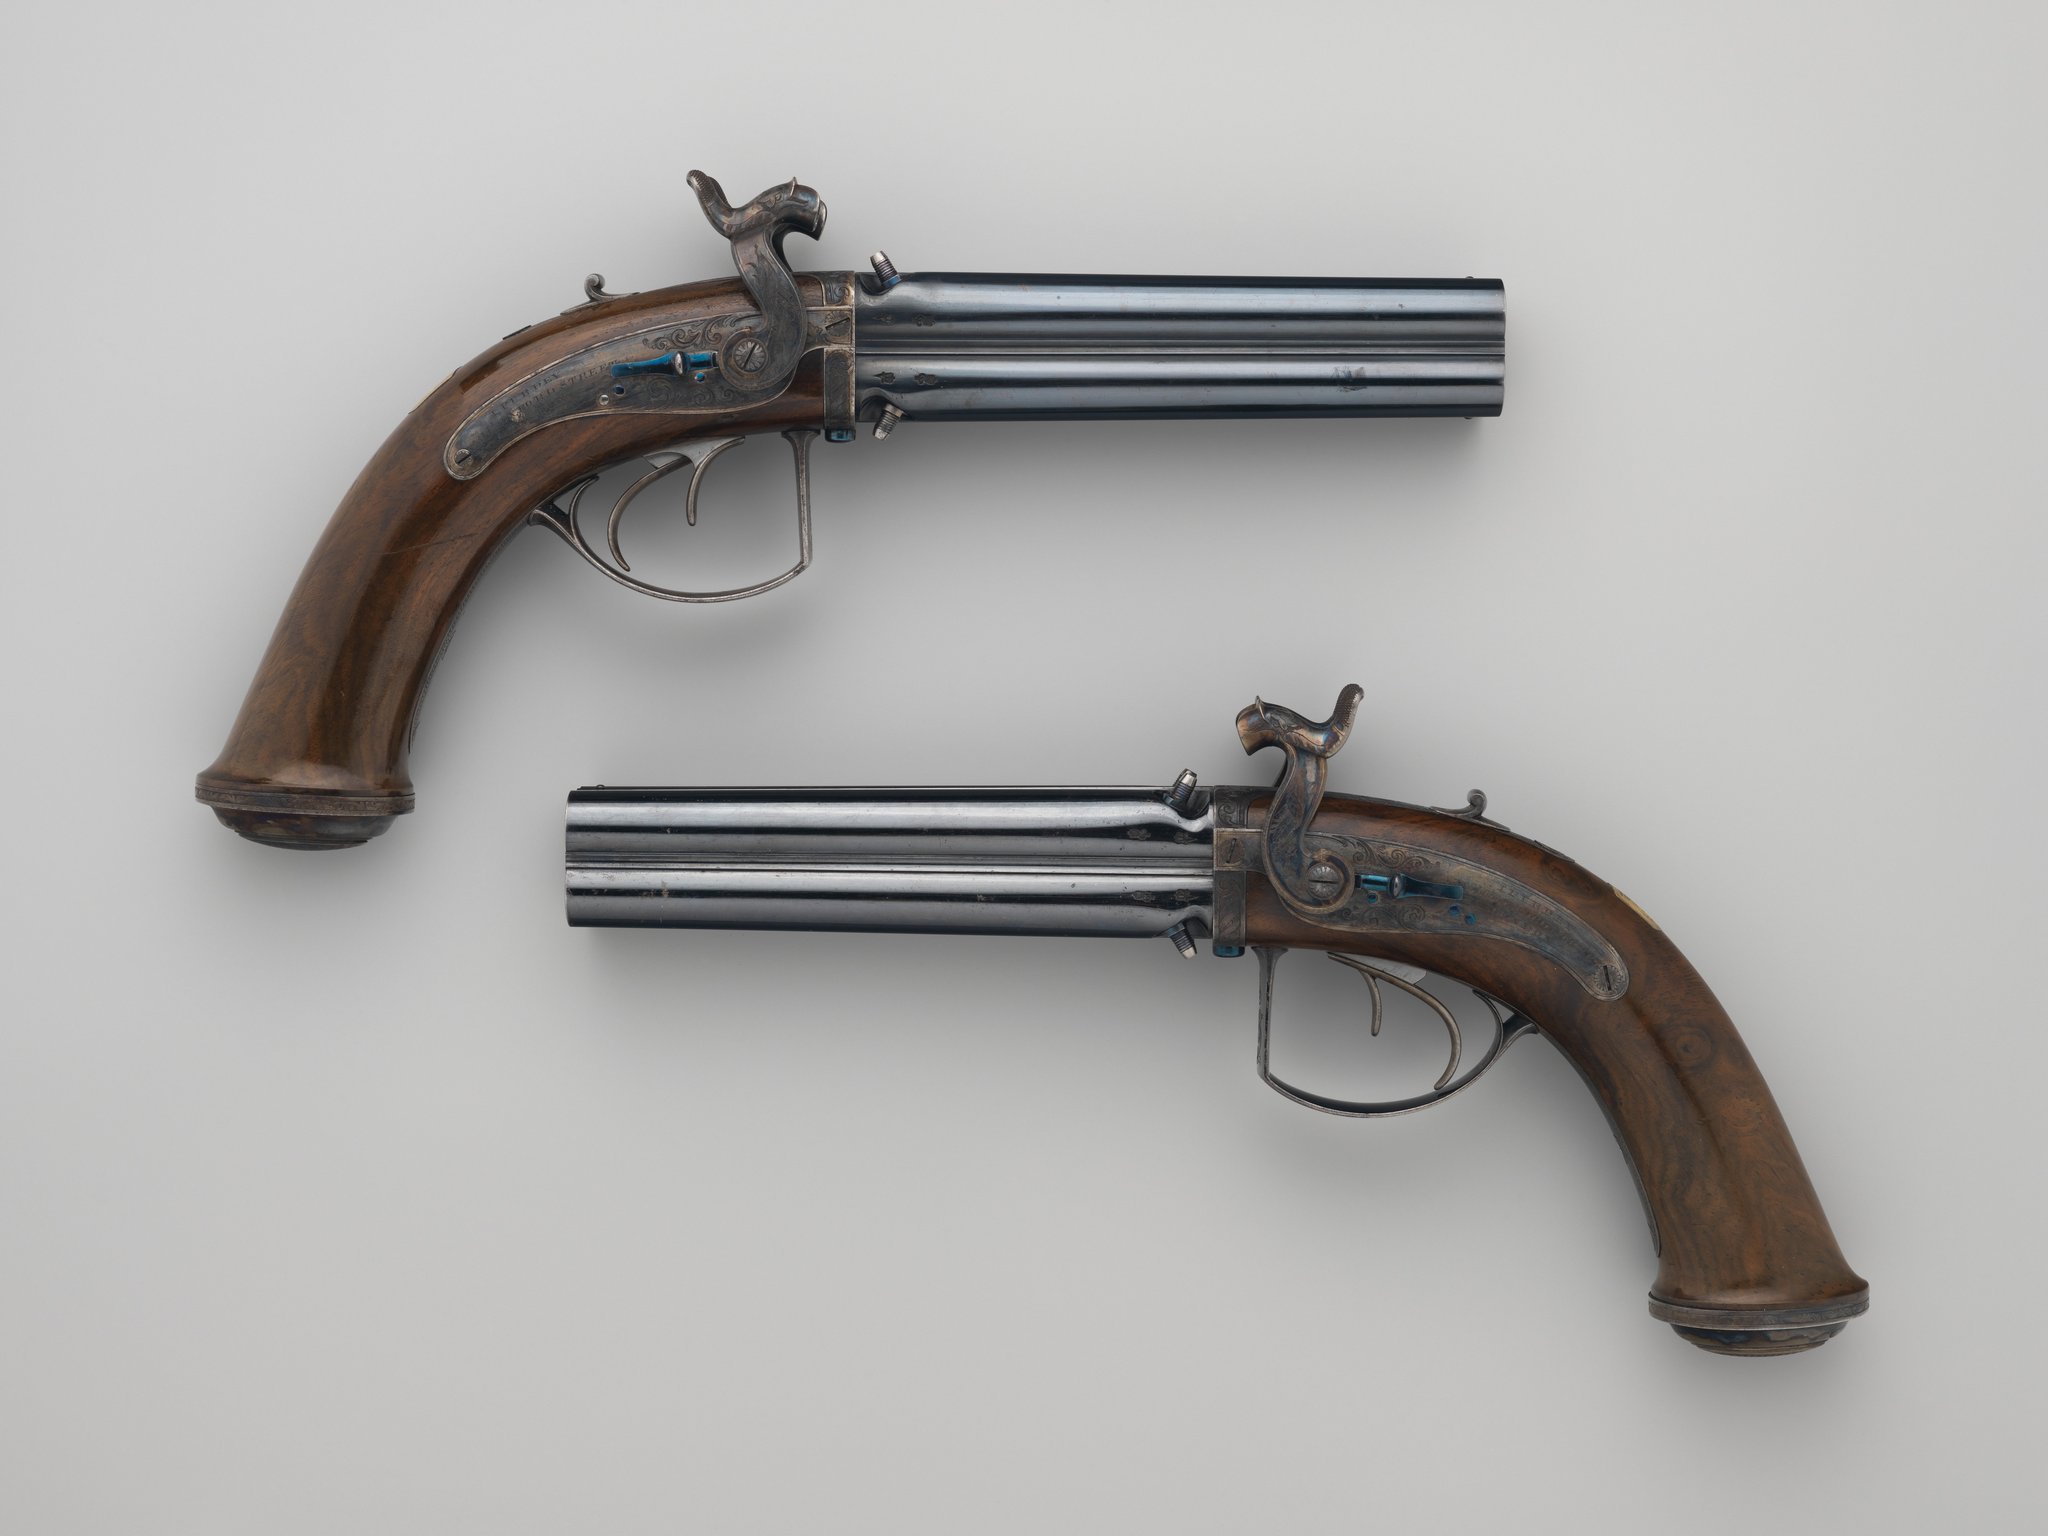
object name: set of four pistol with case and accessory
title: Pair of Four-Barreled Turnover Percussion Pistols of Henry Pelham Fiennes Pelham-Clinton, 4th Duke of Newcastle-under-Lyne (1785–1851), with Pair of Box-Lock Turn-Off Pocket Pistols, Case, and Accessories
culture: british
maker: james purdey the elder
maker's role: gunsmith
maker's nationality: british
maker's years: 1784-1863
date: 1831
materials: brass, copper, gold, horn, ivory, leather, paper, silver, steel, textile, wood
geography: england